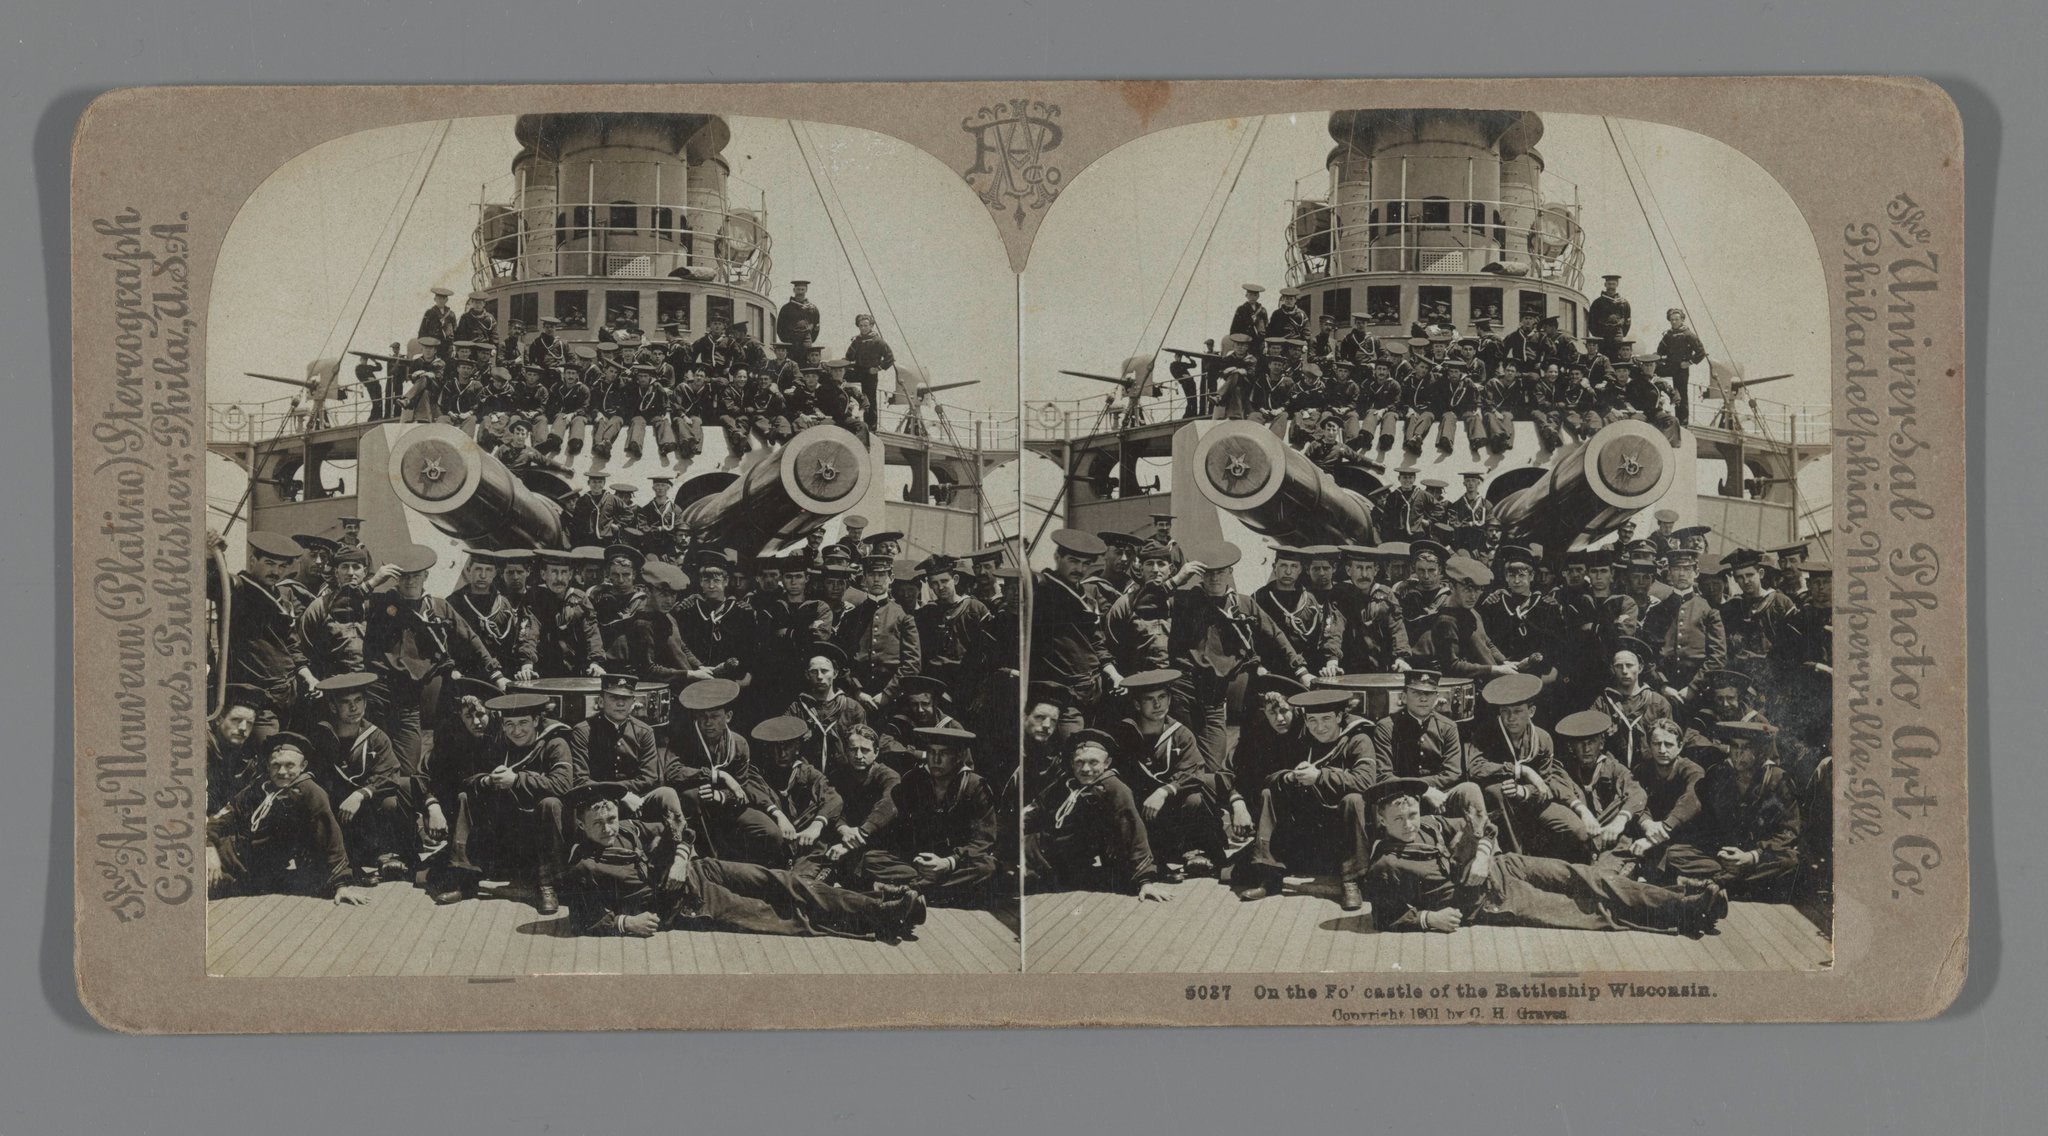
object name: photograph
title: On the Fo' castle of the Battleship Wisconsin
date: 1901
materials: cardboard, photographic support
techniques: gelatin silver print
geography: philadelphia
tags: warfare; military affairs (+ motor ships)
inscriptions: date